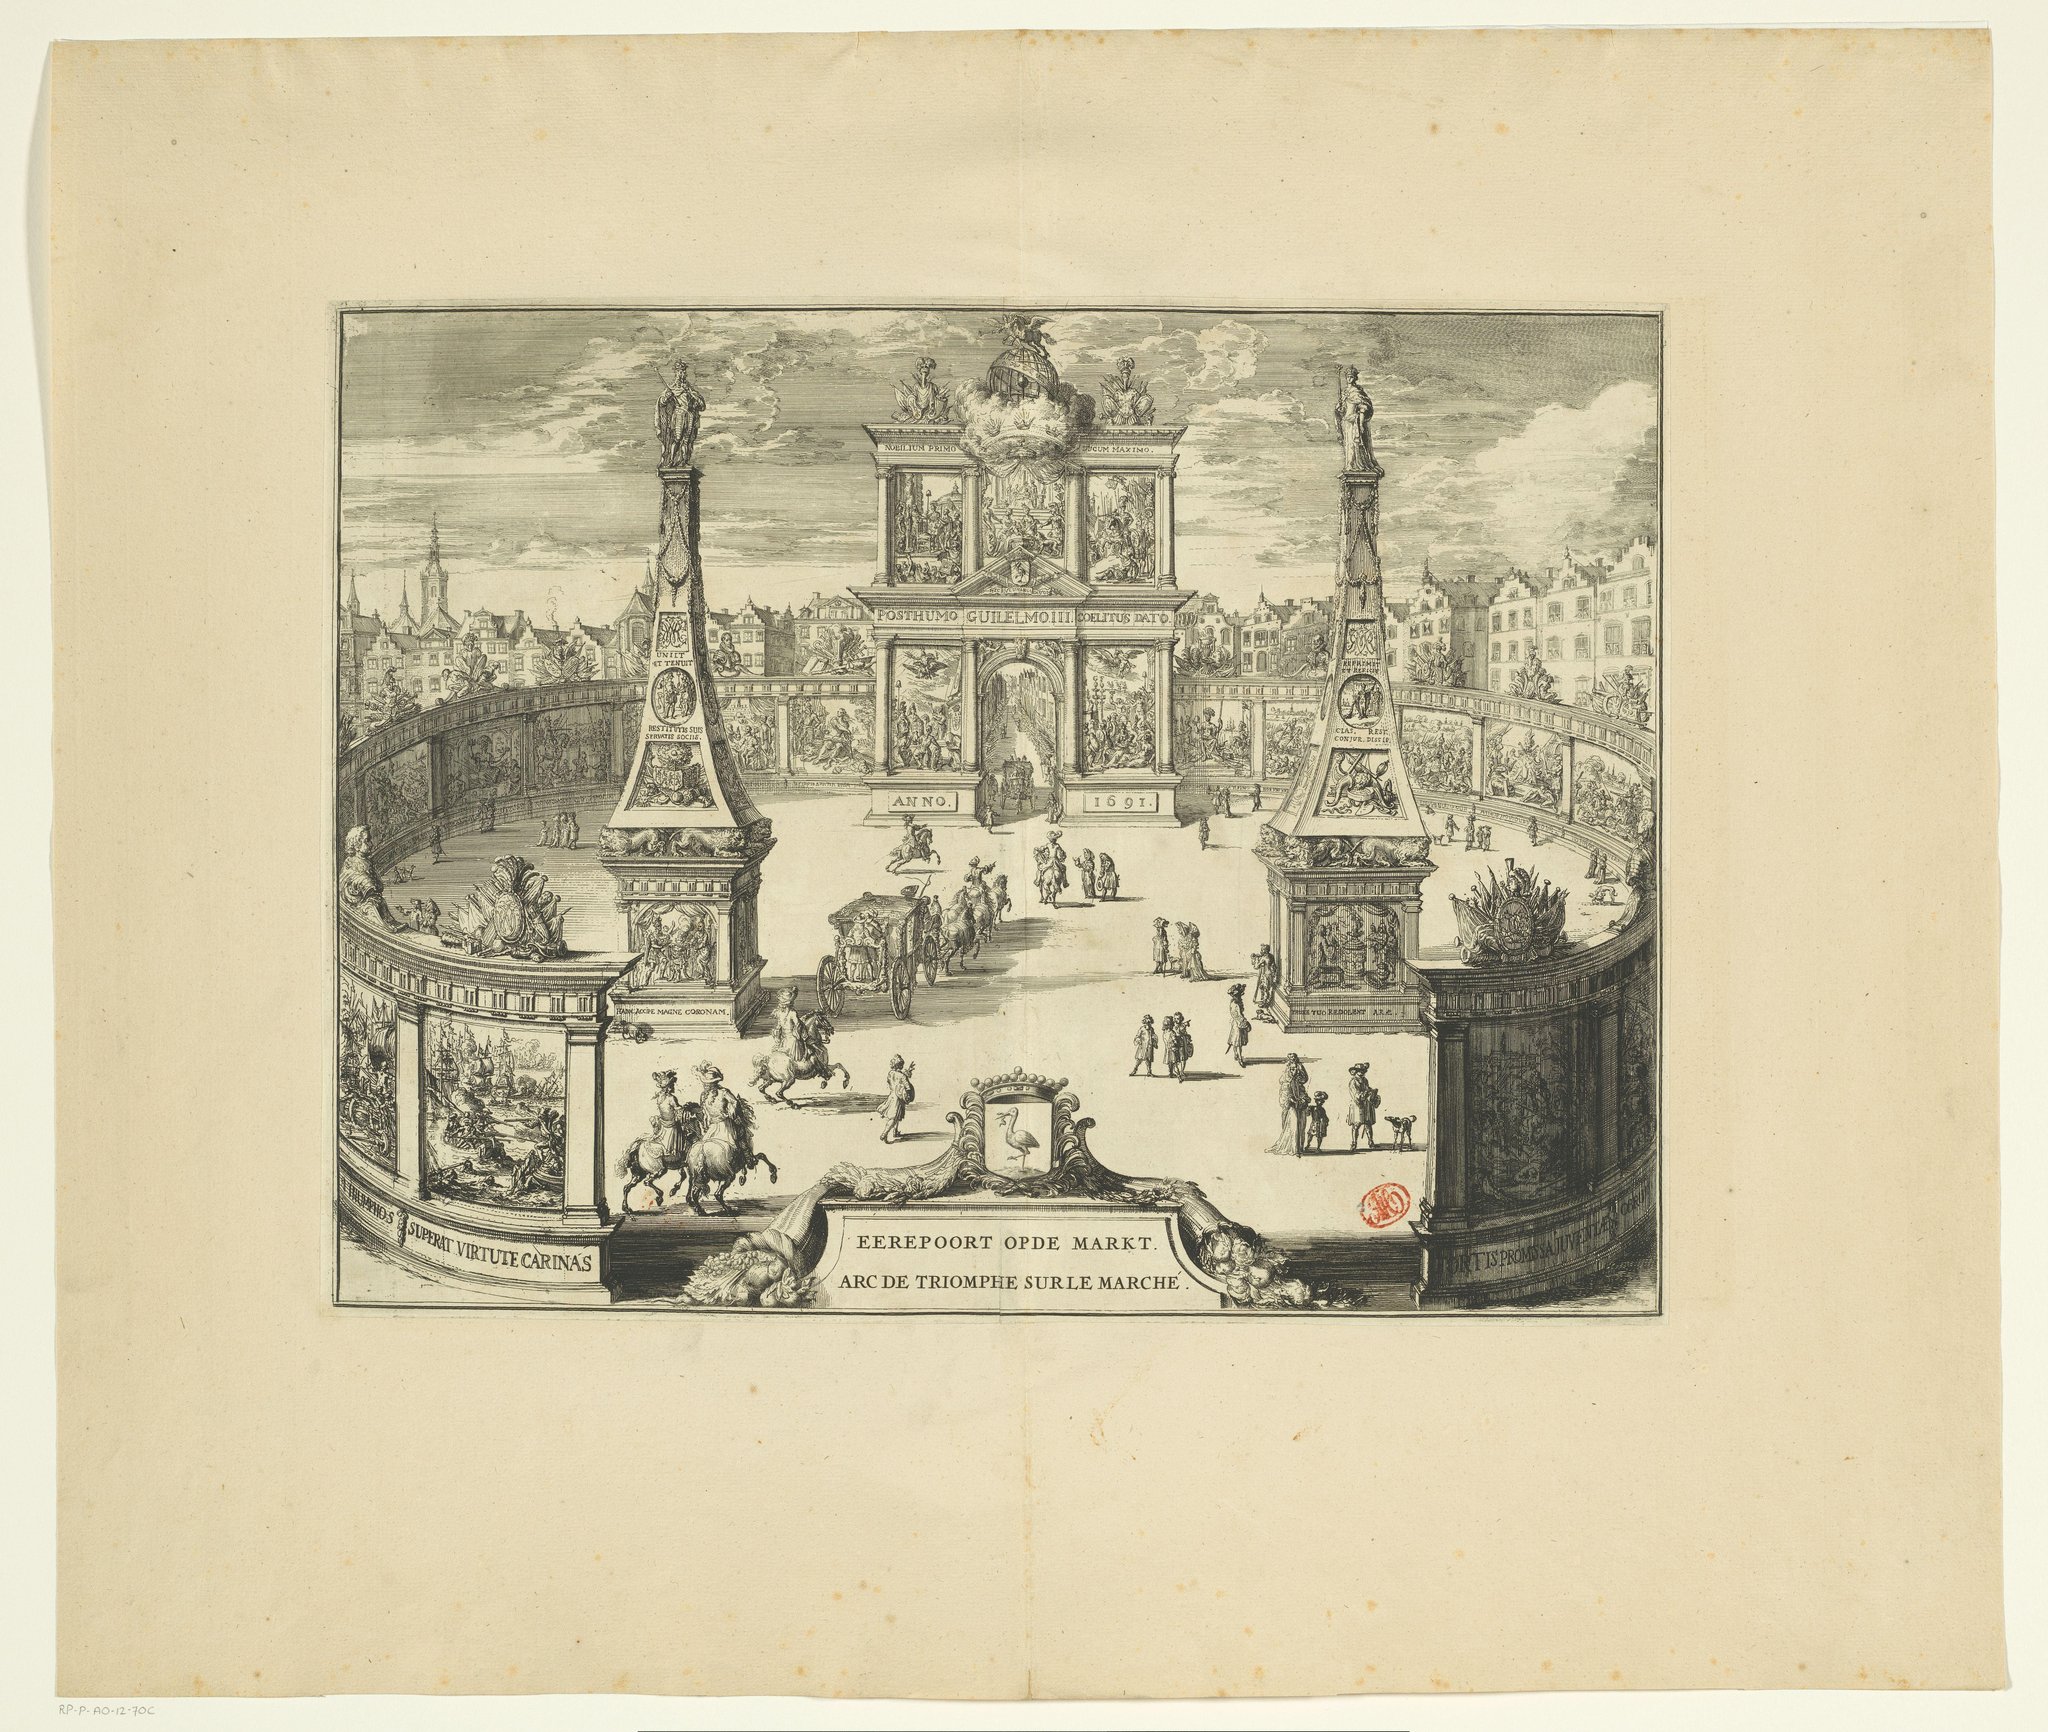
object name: print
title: Eerepoort opde markt / Arc de triomphe sur le marché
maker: romeyn de hooghe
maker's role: draughtsman, goldsmith, painter, print maker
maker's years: 1645-1708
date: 1691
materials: paper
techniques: etching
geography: northern netherlands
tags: the hague, william iii (prince of orange and king of england, scotland, and ireland), coat of arms (as symbol of the state, etc.) (+ city; municipal), triumphal entry and public reception, pageant, 'entrée solennelle', 'joyeuse entrée'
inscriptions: collector's mark: Lugt 195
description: Gezicht op de erepoort op de markt, opgericht voor de intocht van stadhouder-koning Willem III te Den Haag, 5 februari 1691. Voor de poort twee obelisken en twee halfronde vleugels, alles versierd met historische en mythologische voorstellingen met opschriften in het Latijn.